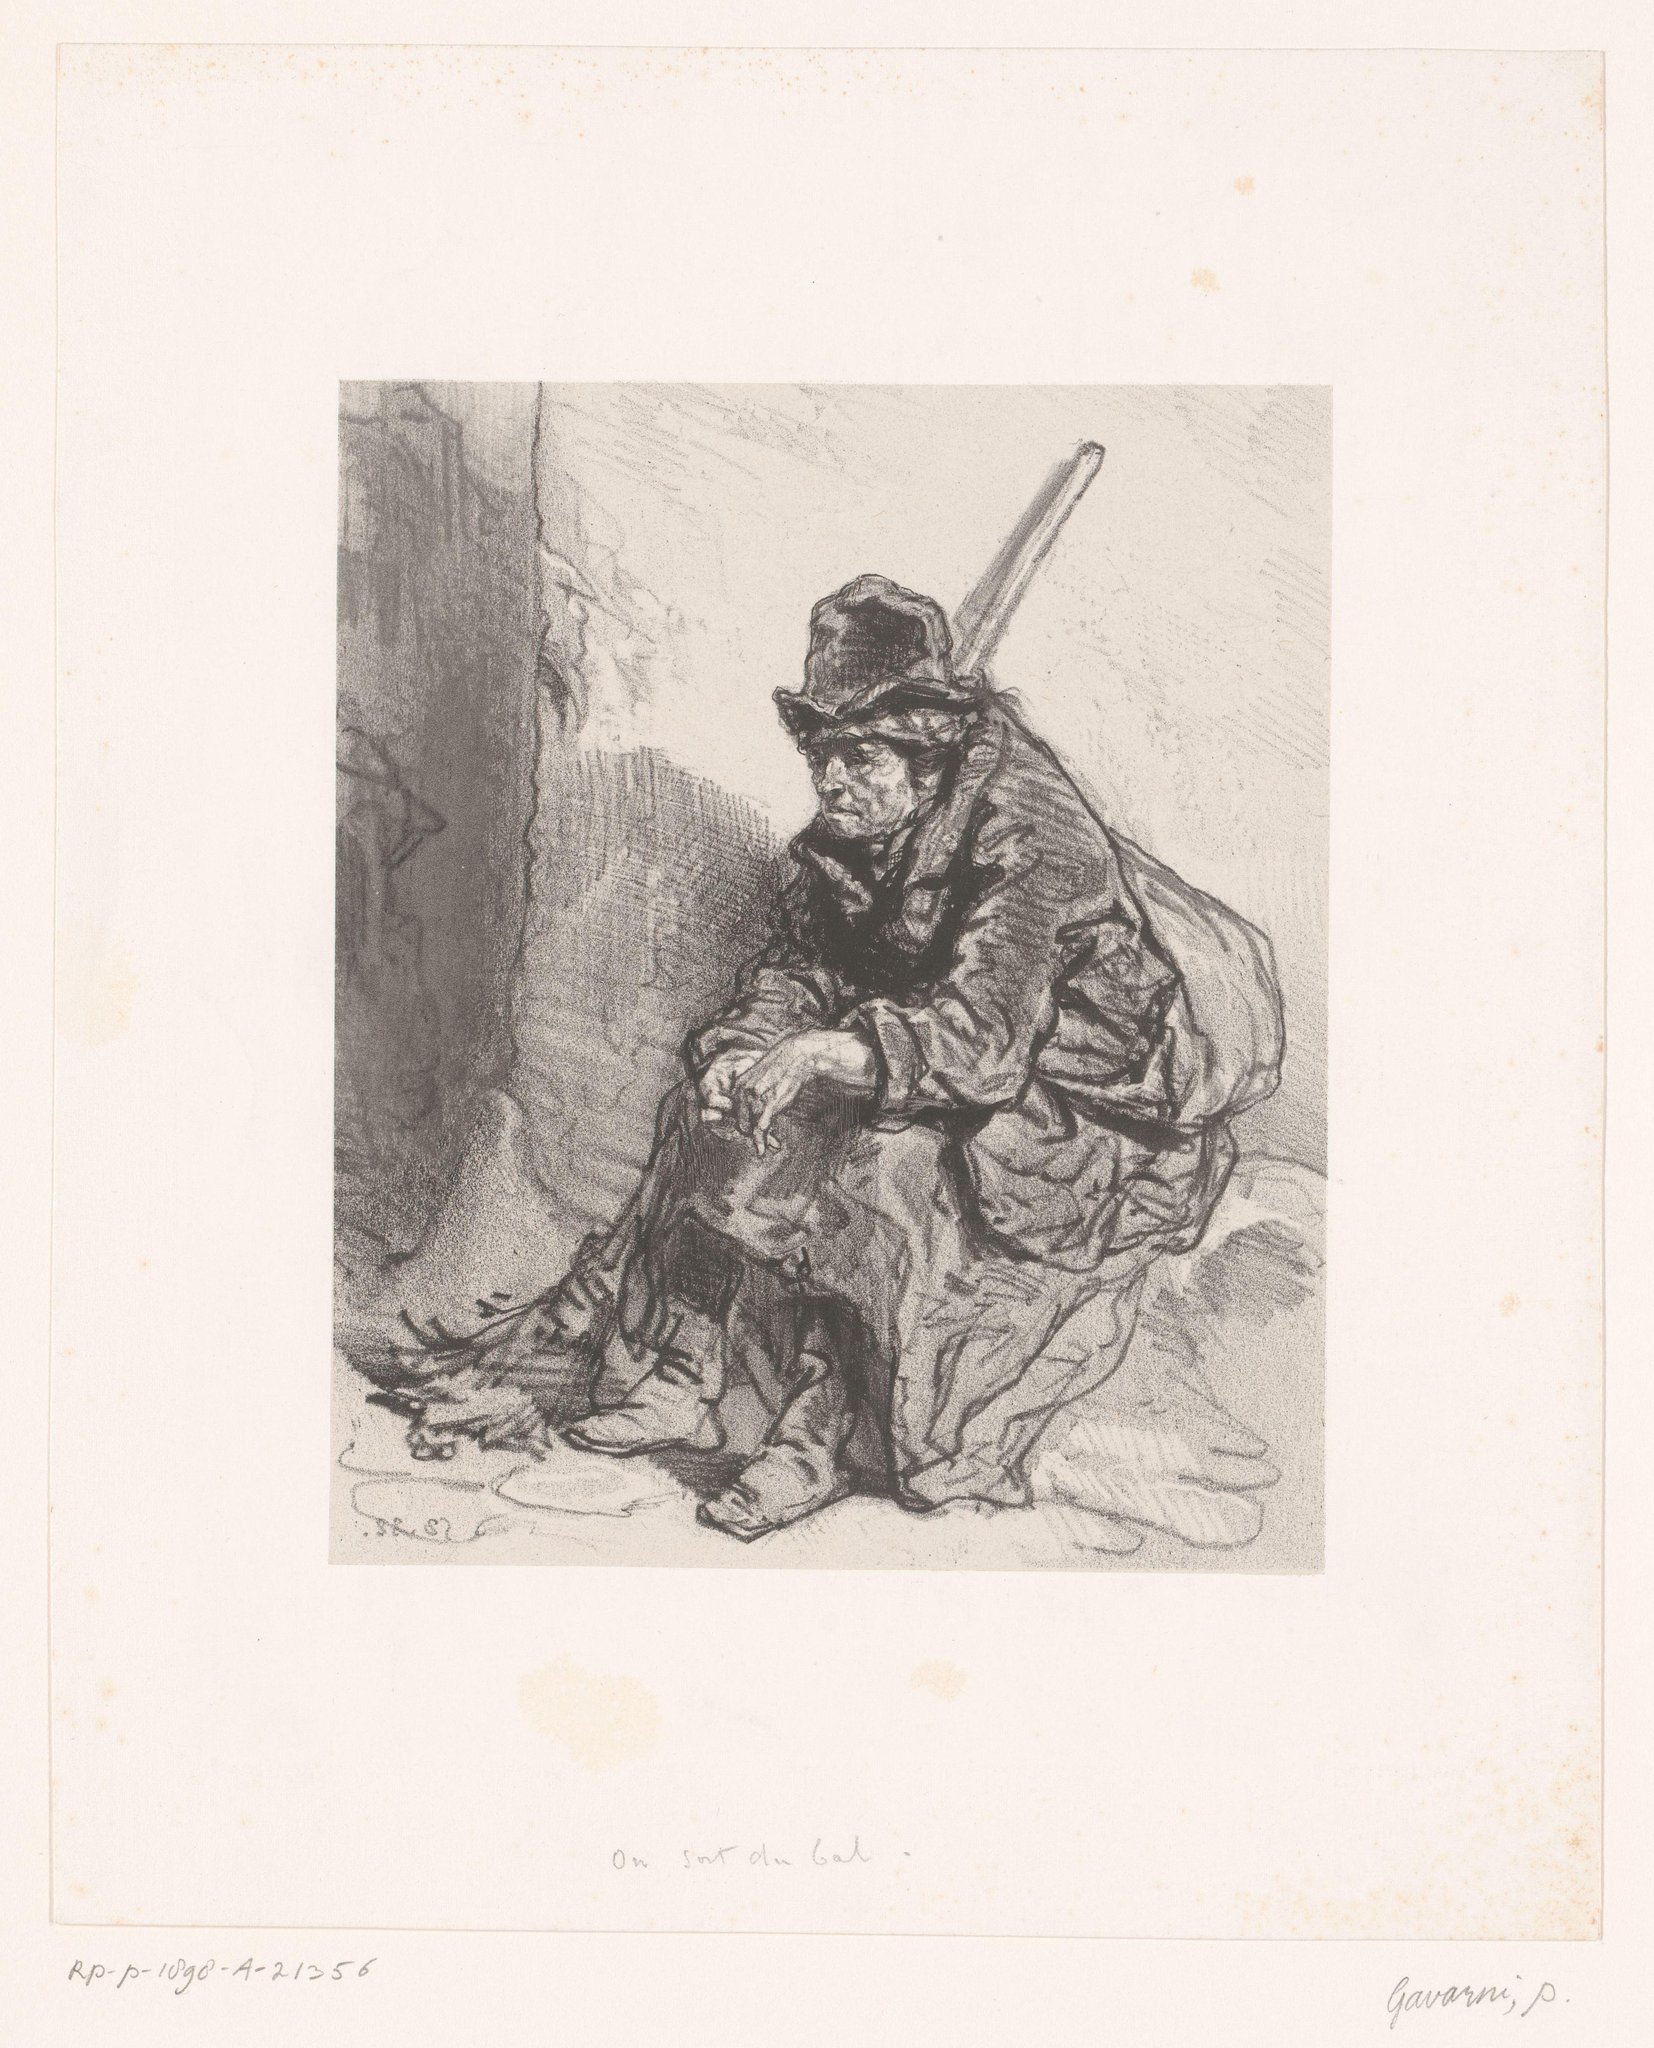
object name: print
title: Arme lieden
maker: paul gavarni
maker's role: draughtsman, print maker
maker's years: 1804-1866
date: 1852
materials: paper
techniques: lithograph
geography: paris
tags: old woman, street sweeping, street sweeper, sitting on an elevation - aa - female human figure, resting - bb - out of doors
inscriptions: collector's mark: Lugt 964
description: Prent gebruikt voor: Paris (journal), 30 november 1852.